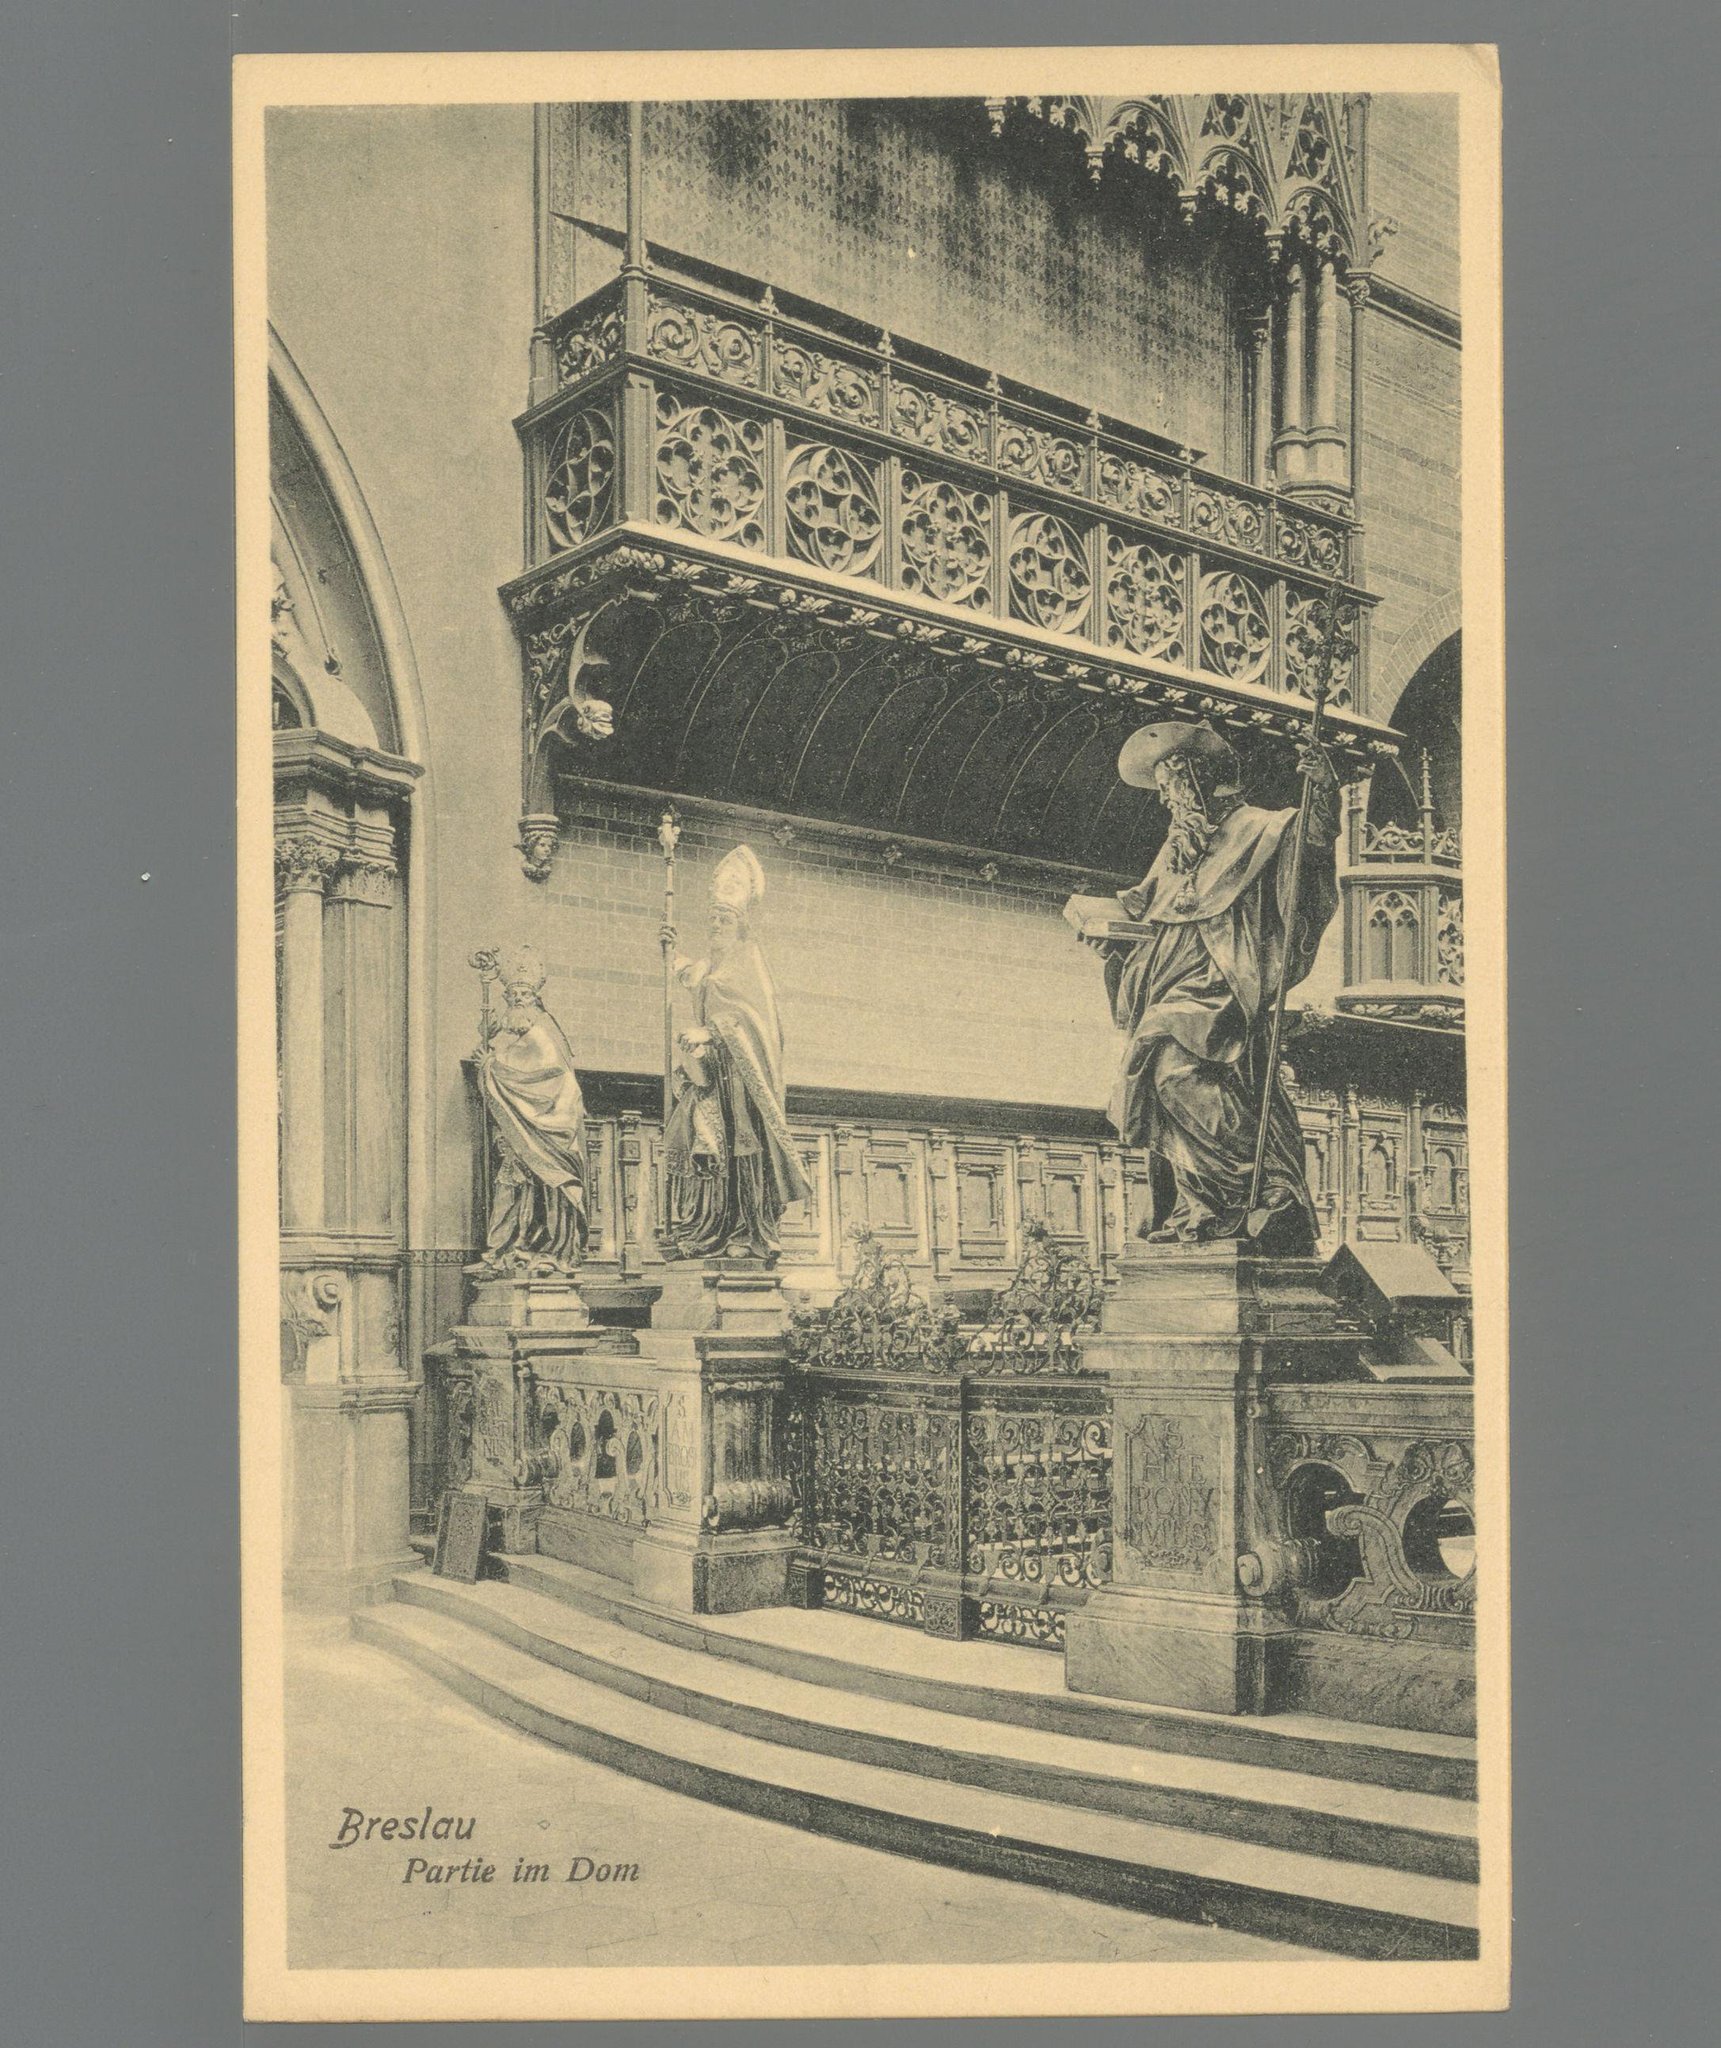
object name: ansichtkaart, prentbriefkaart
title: Breslau. Partie im Dom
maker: Anonymous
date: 1908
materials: cardboard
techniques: photograph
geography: leipzig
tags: interior of church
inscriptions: date